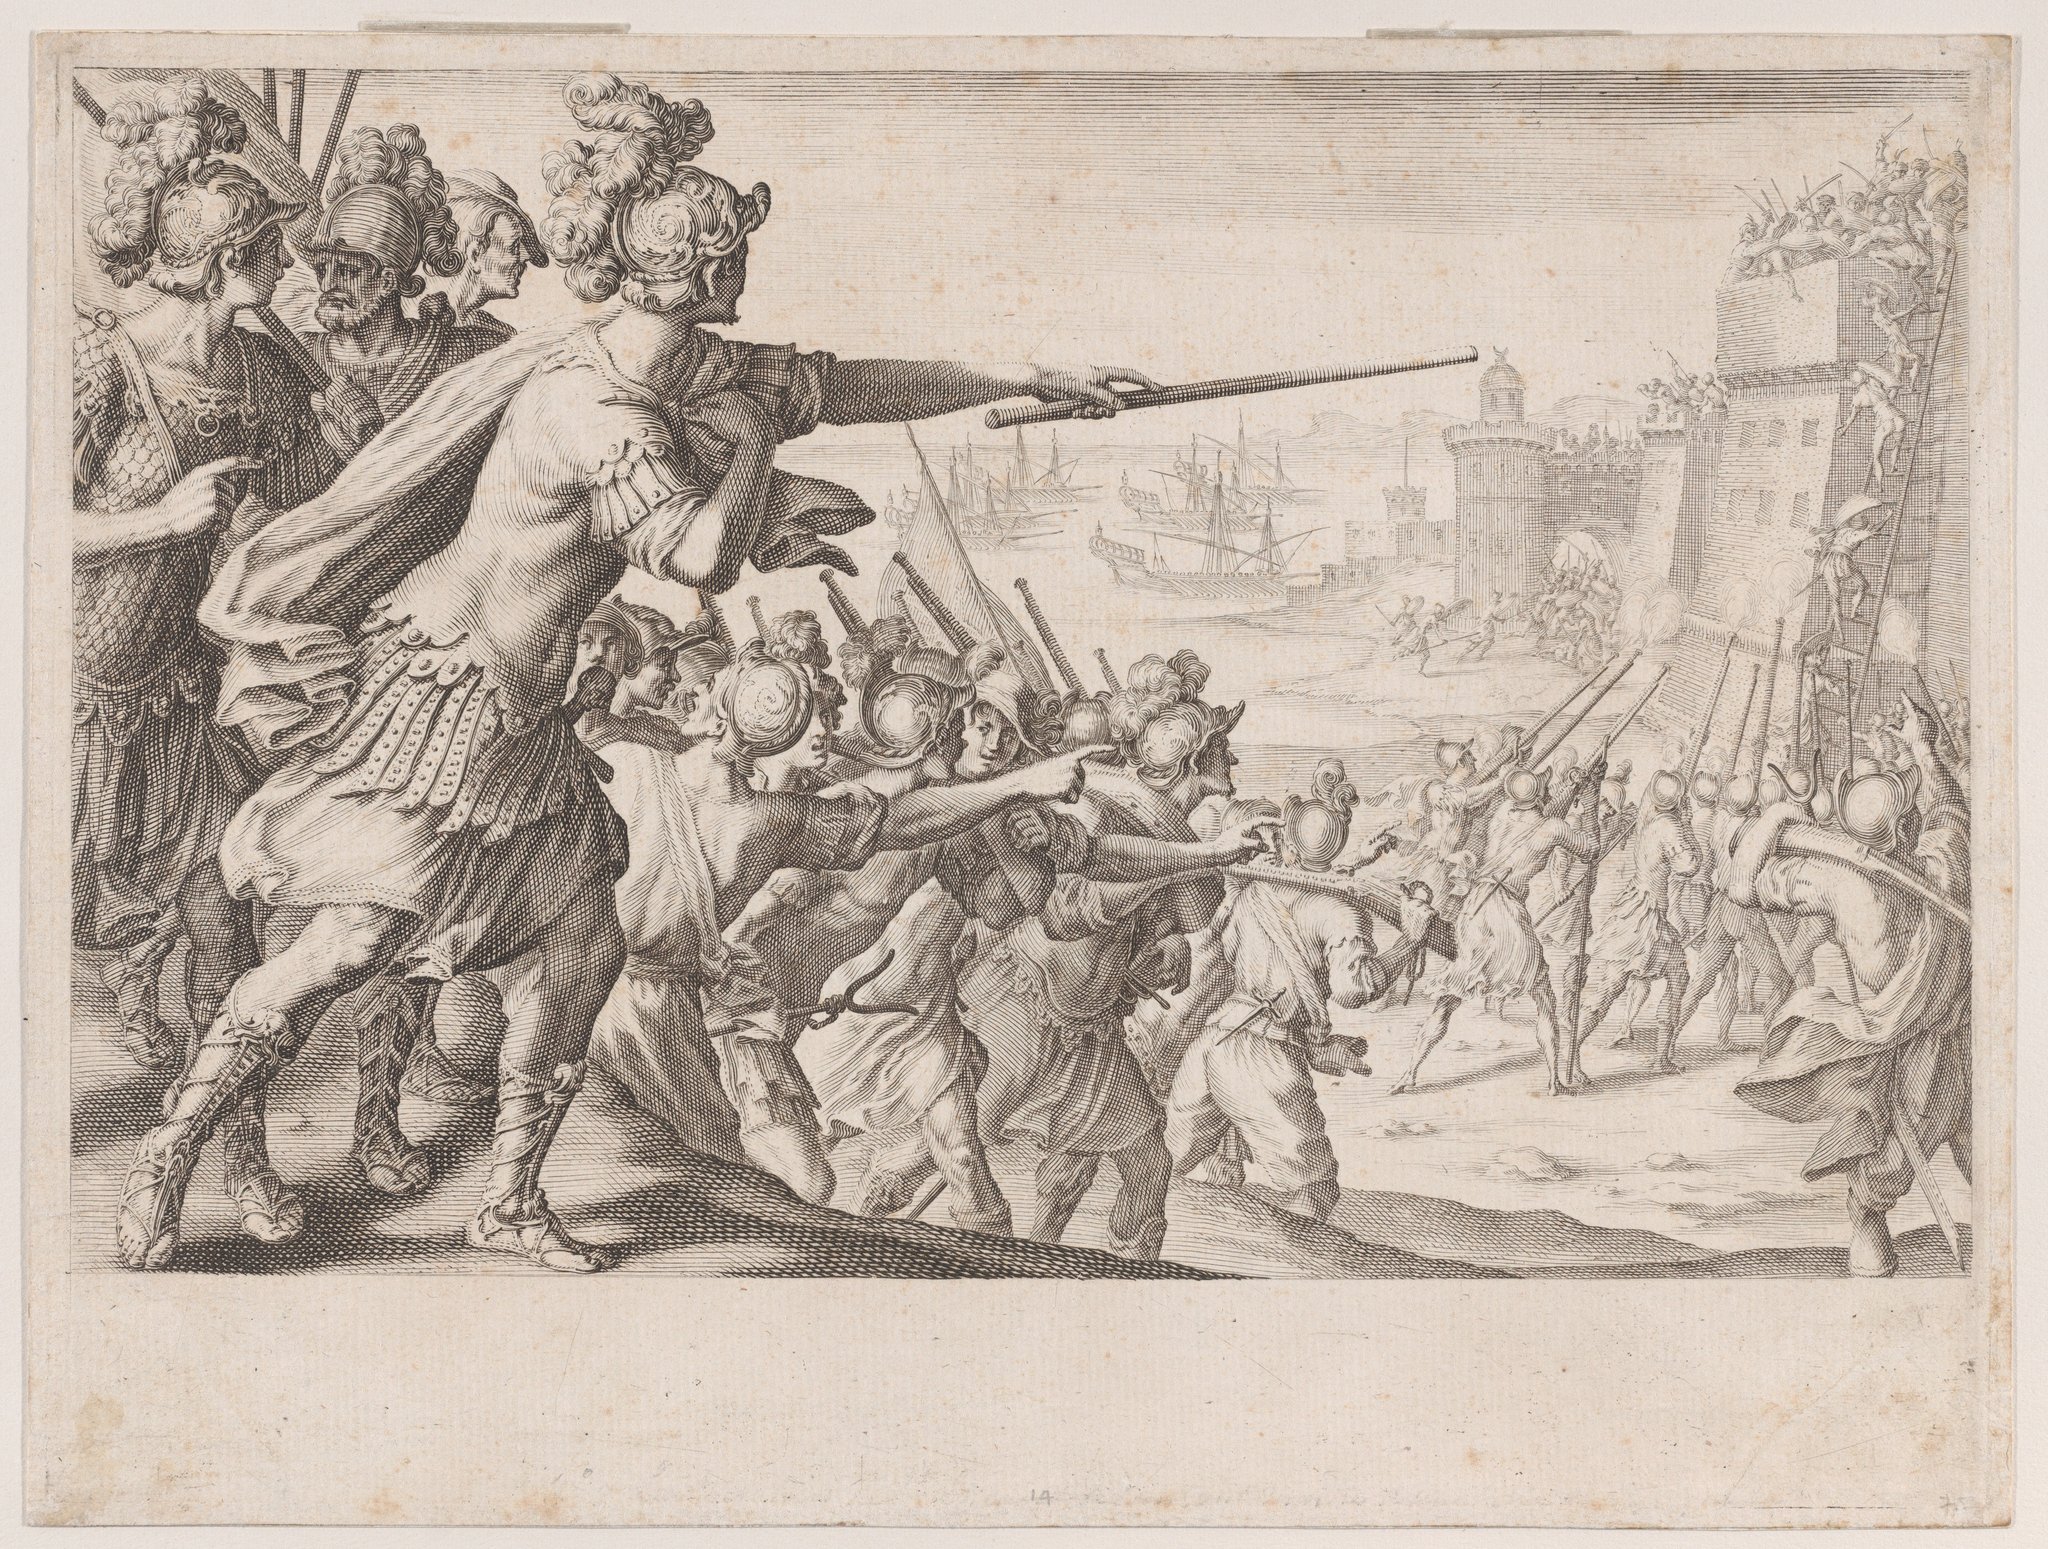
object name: print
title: Prise de la Ville de Bone (Capture of the City of Bonne), from "La Vie de Ferdinand Ier de Médicis série appelée aussi Les Batailles des Médicis" (The Life of Ferdinand I de'Medici also called The Medici Battles)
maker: jacques callot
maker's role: artist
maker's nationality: french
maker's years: 1592-1635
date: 1614-1620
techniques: engraving